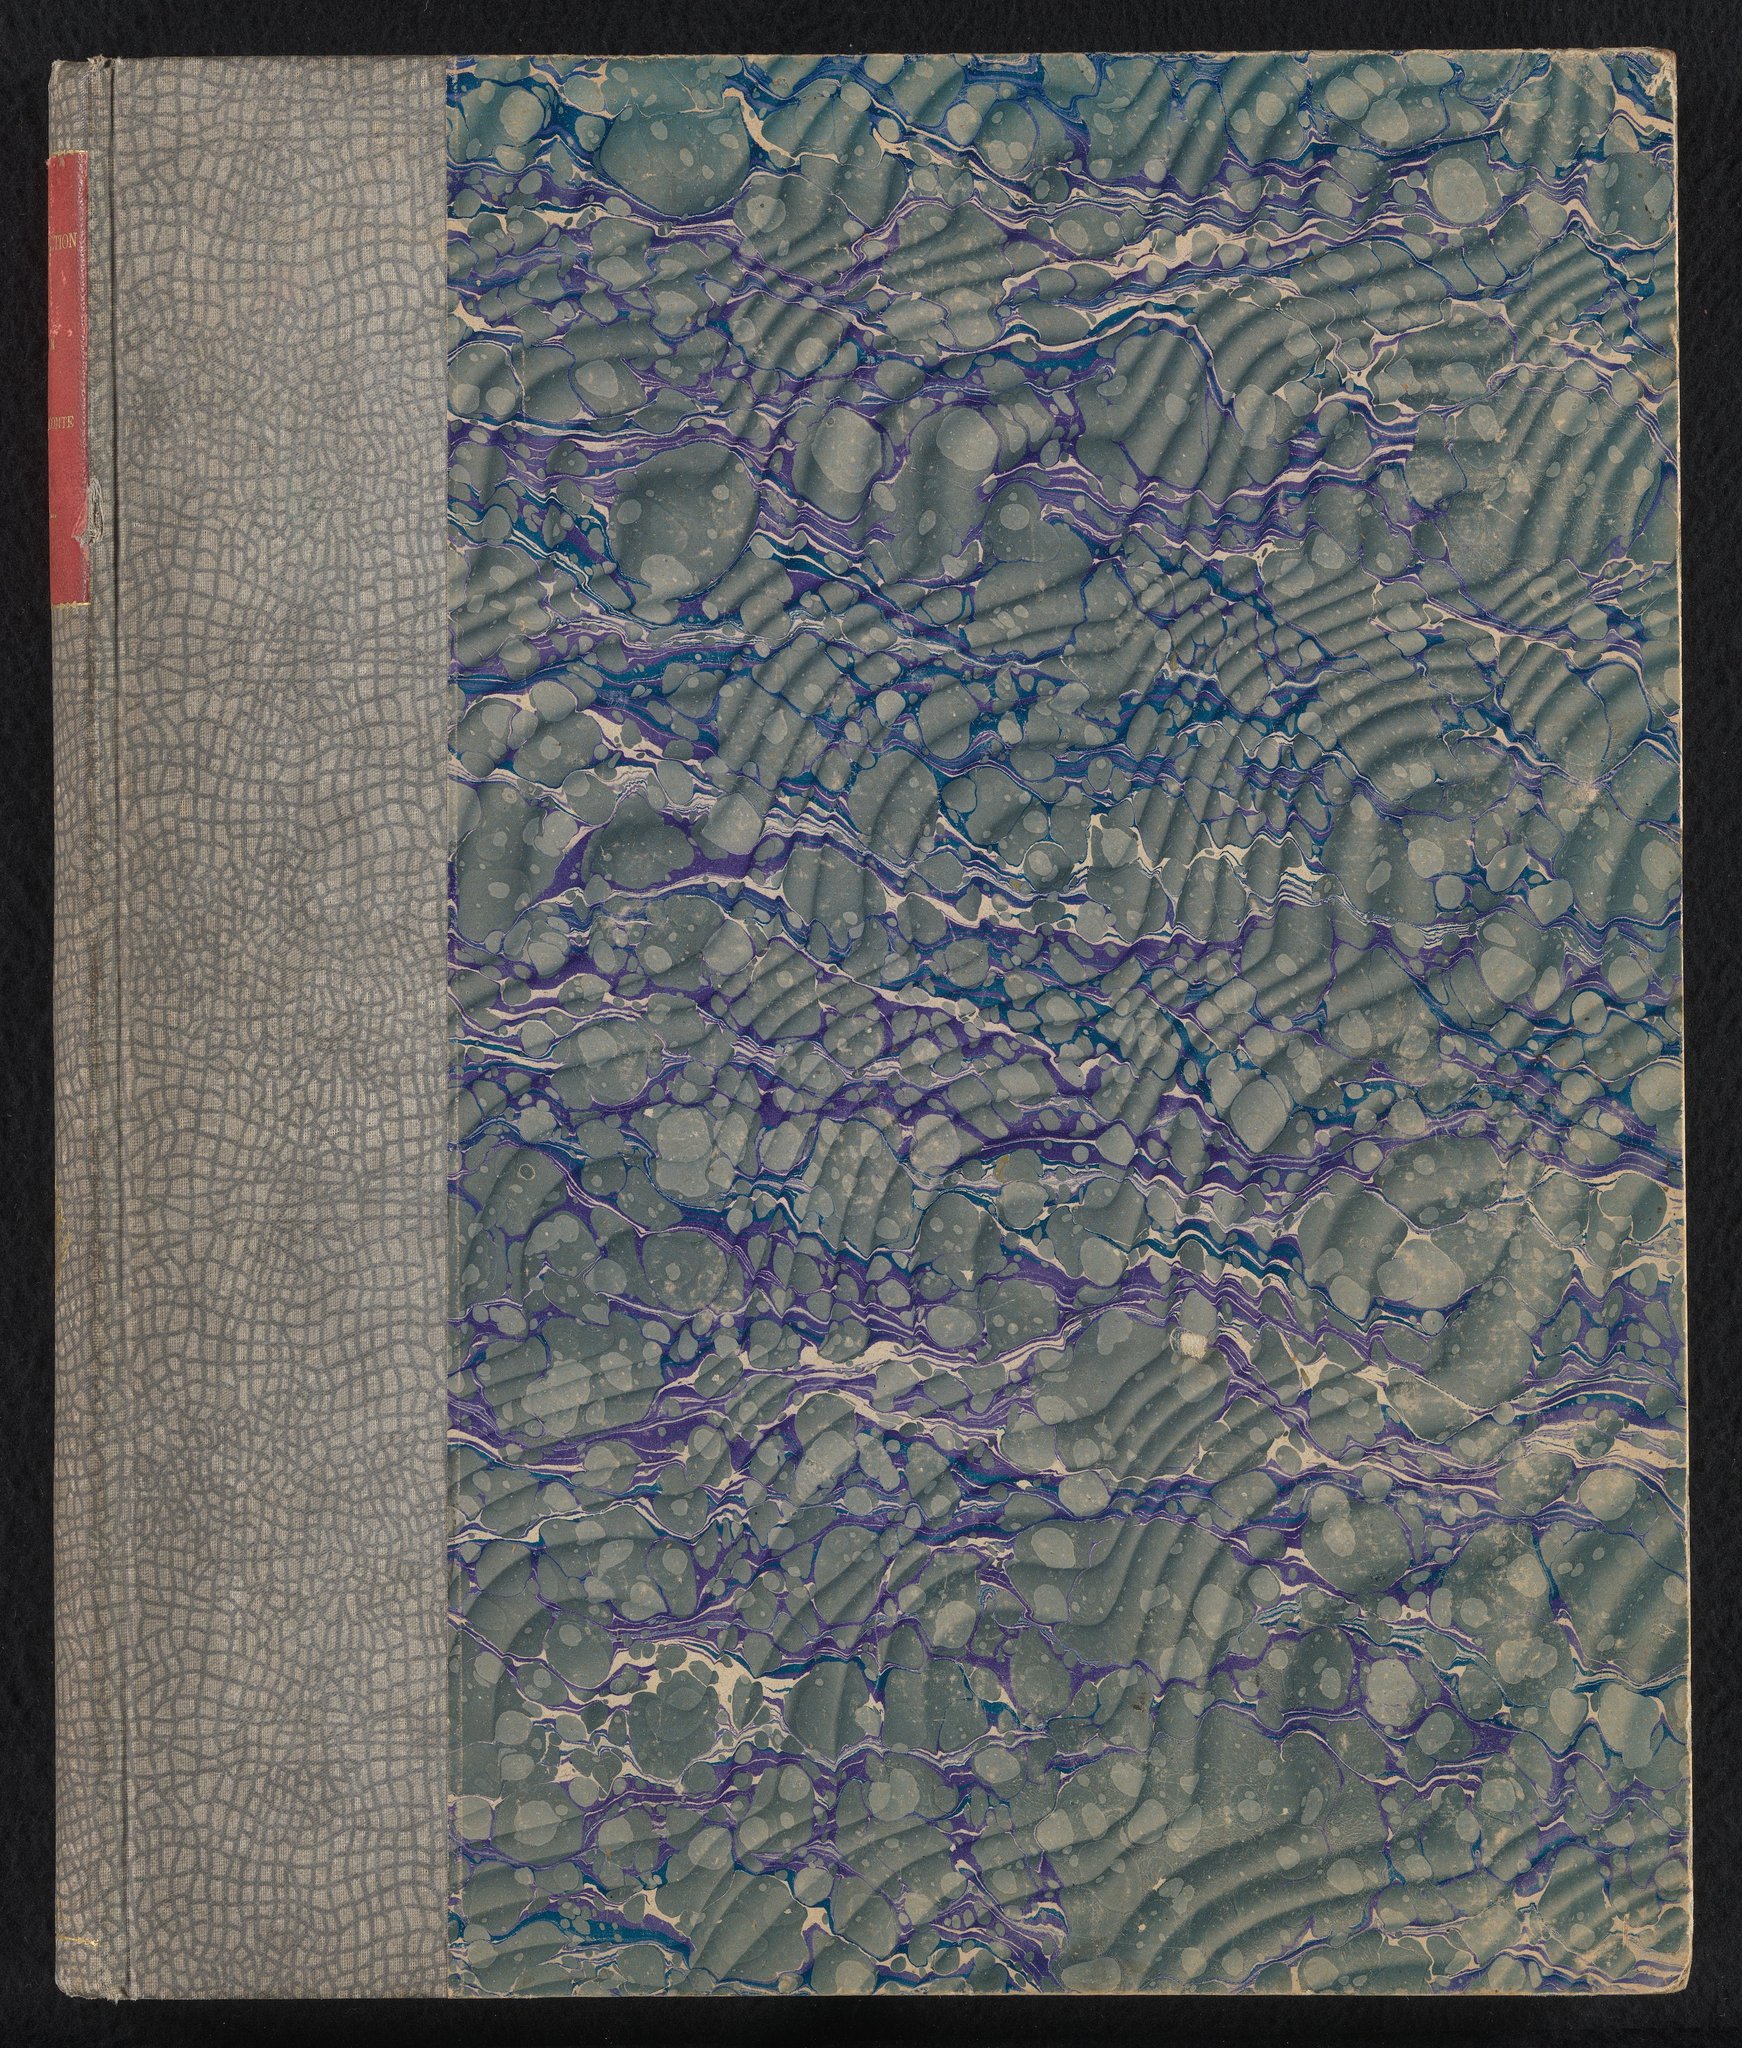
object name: catalog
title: Catalogue des tableaux anciens de grands maîtres (…) et des tableaux modernes composant la collection de M. le Vicomte A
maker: m. le vicomte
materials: cardboard, leather, linen, paper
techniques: albumen print, printing, marbled paper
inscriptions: inscription, date: ‘OCT/ 2008’, inscription: ‘80€’, address: ‘PARIS/ IMPRIMERIES RÉunies/ MOTTEROZ/ ADMINISTRATEUR-DIRECTEUR/ Rue Mignon 2’